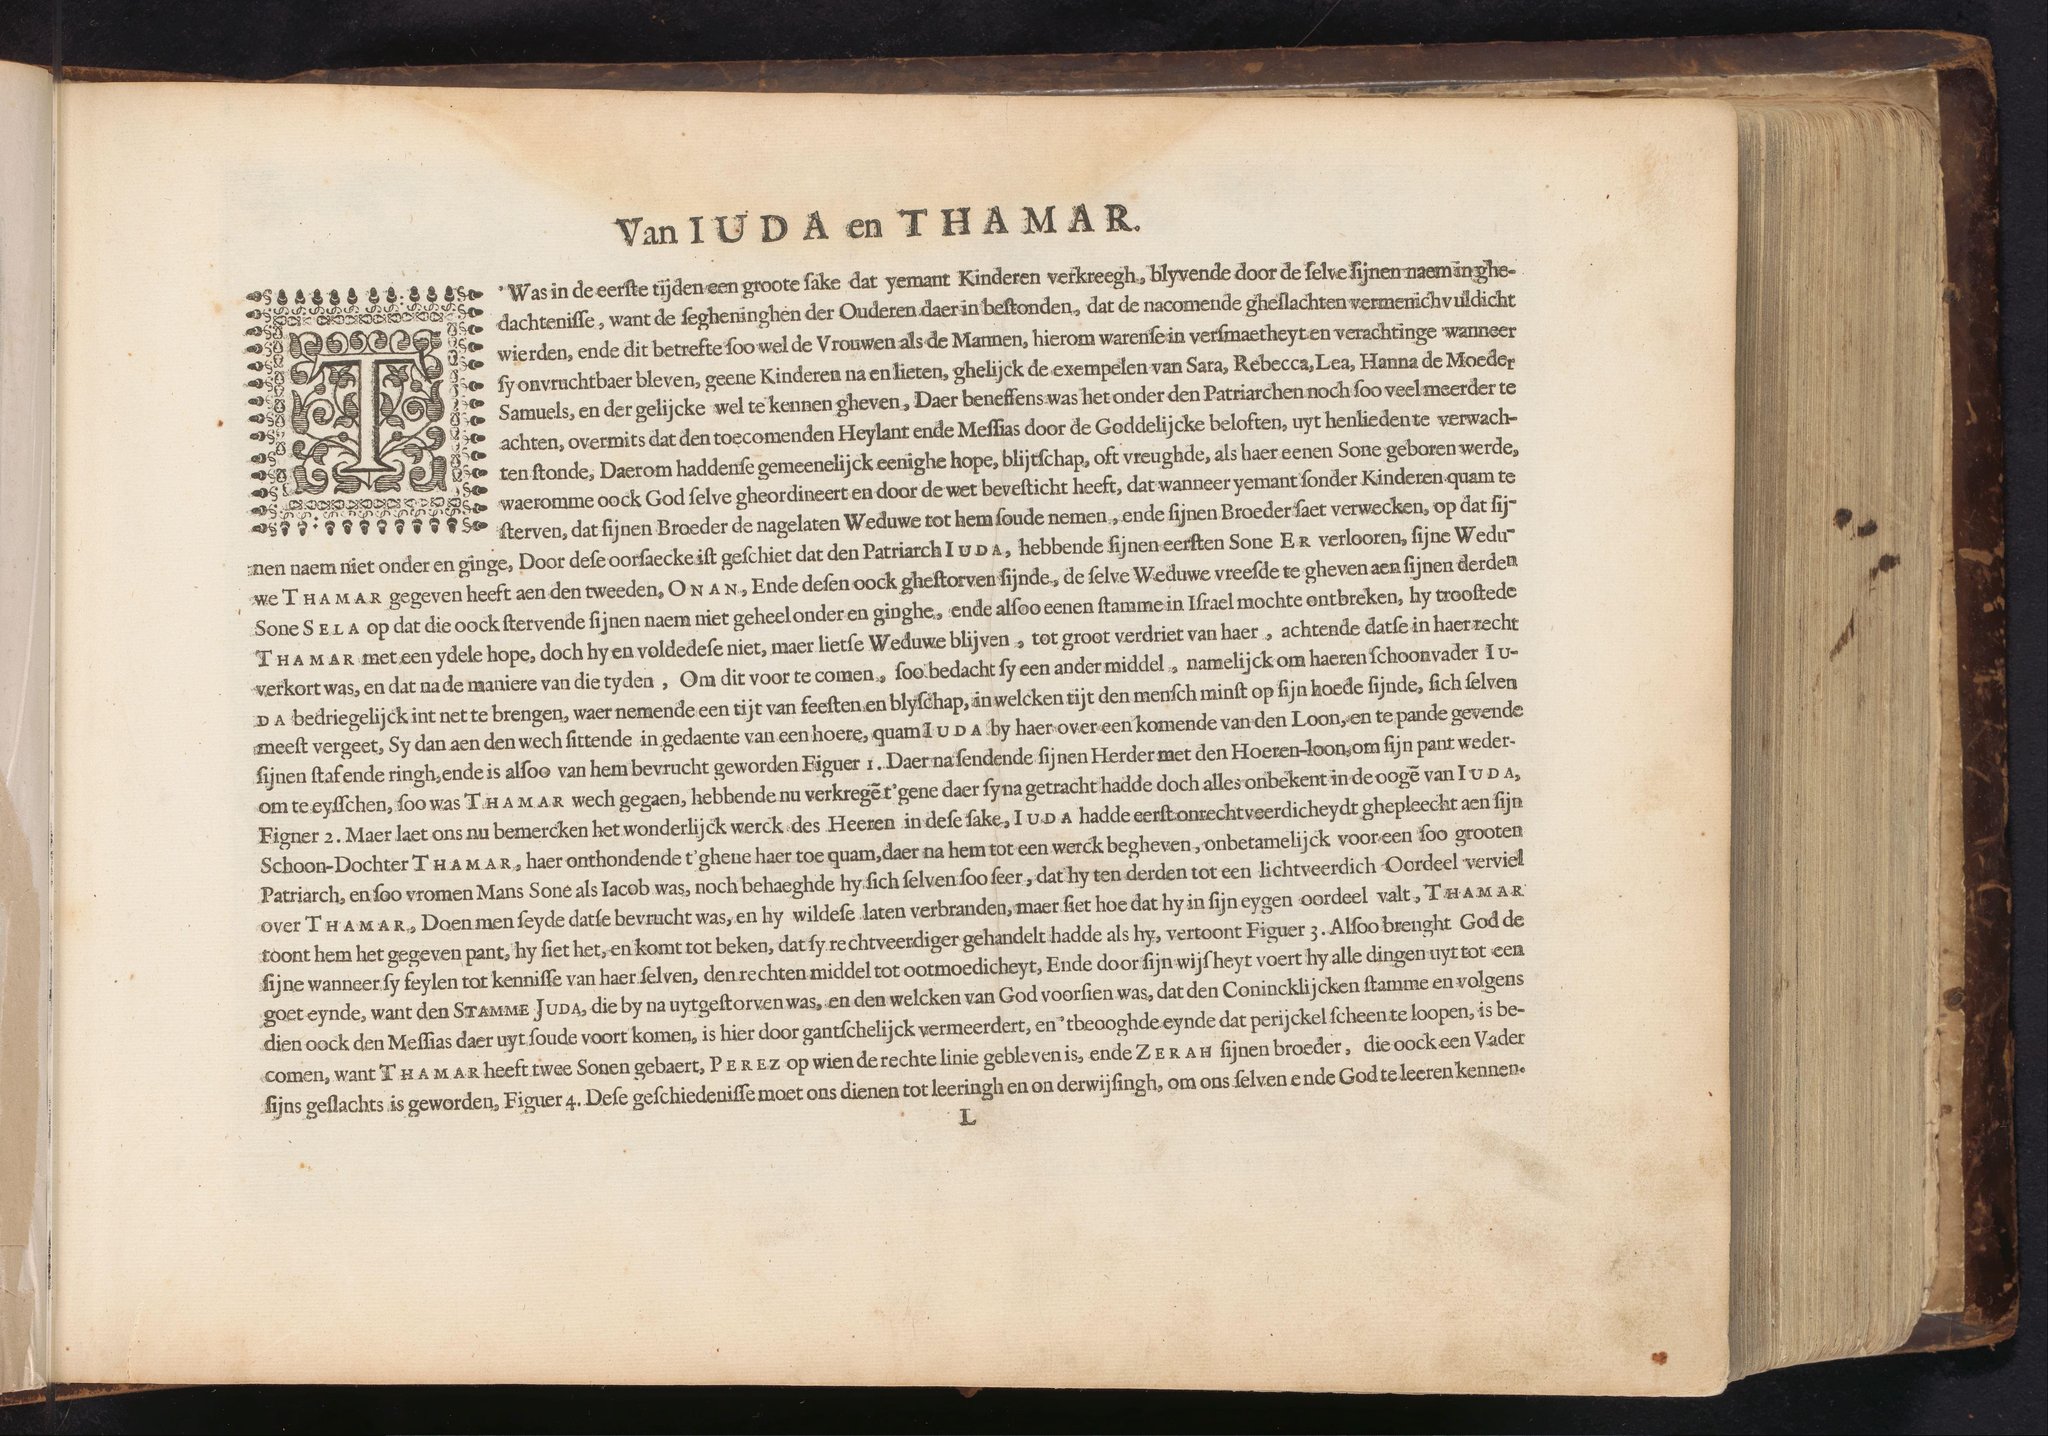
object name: album leaf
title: Van Iuda en Thamar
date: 1646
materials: paper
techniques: letterpress printing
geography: alkmaar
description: Tekstblad bij een serie prenten over de geschiedenis van Juda en Tamar. Dit blad maakt deel uit van een album.